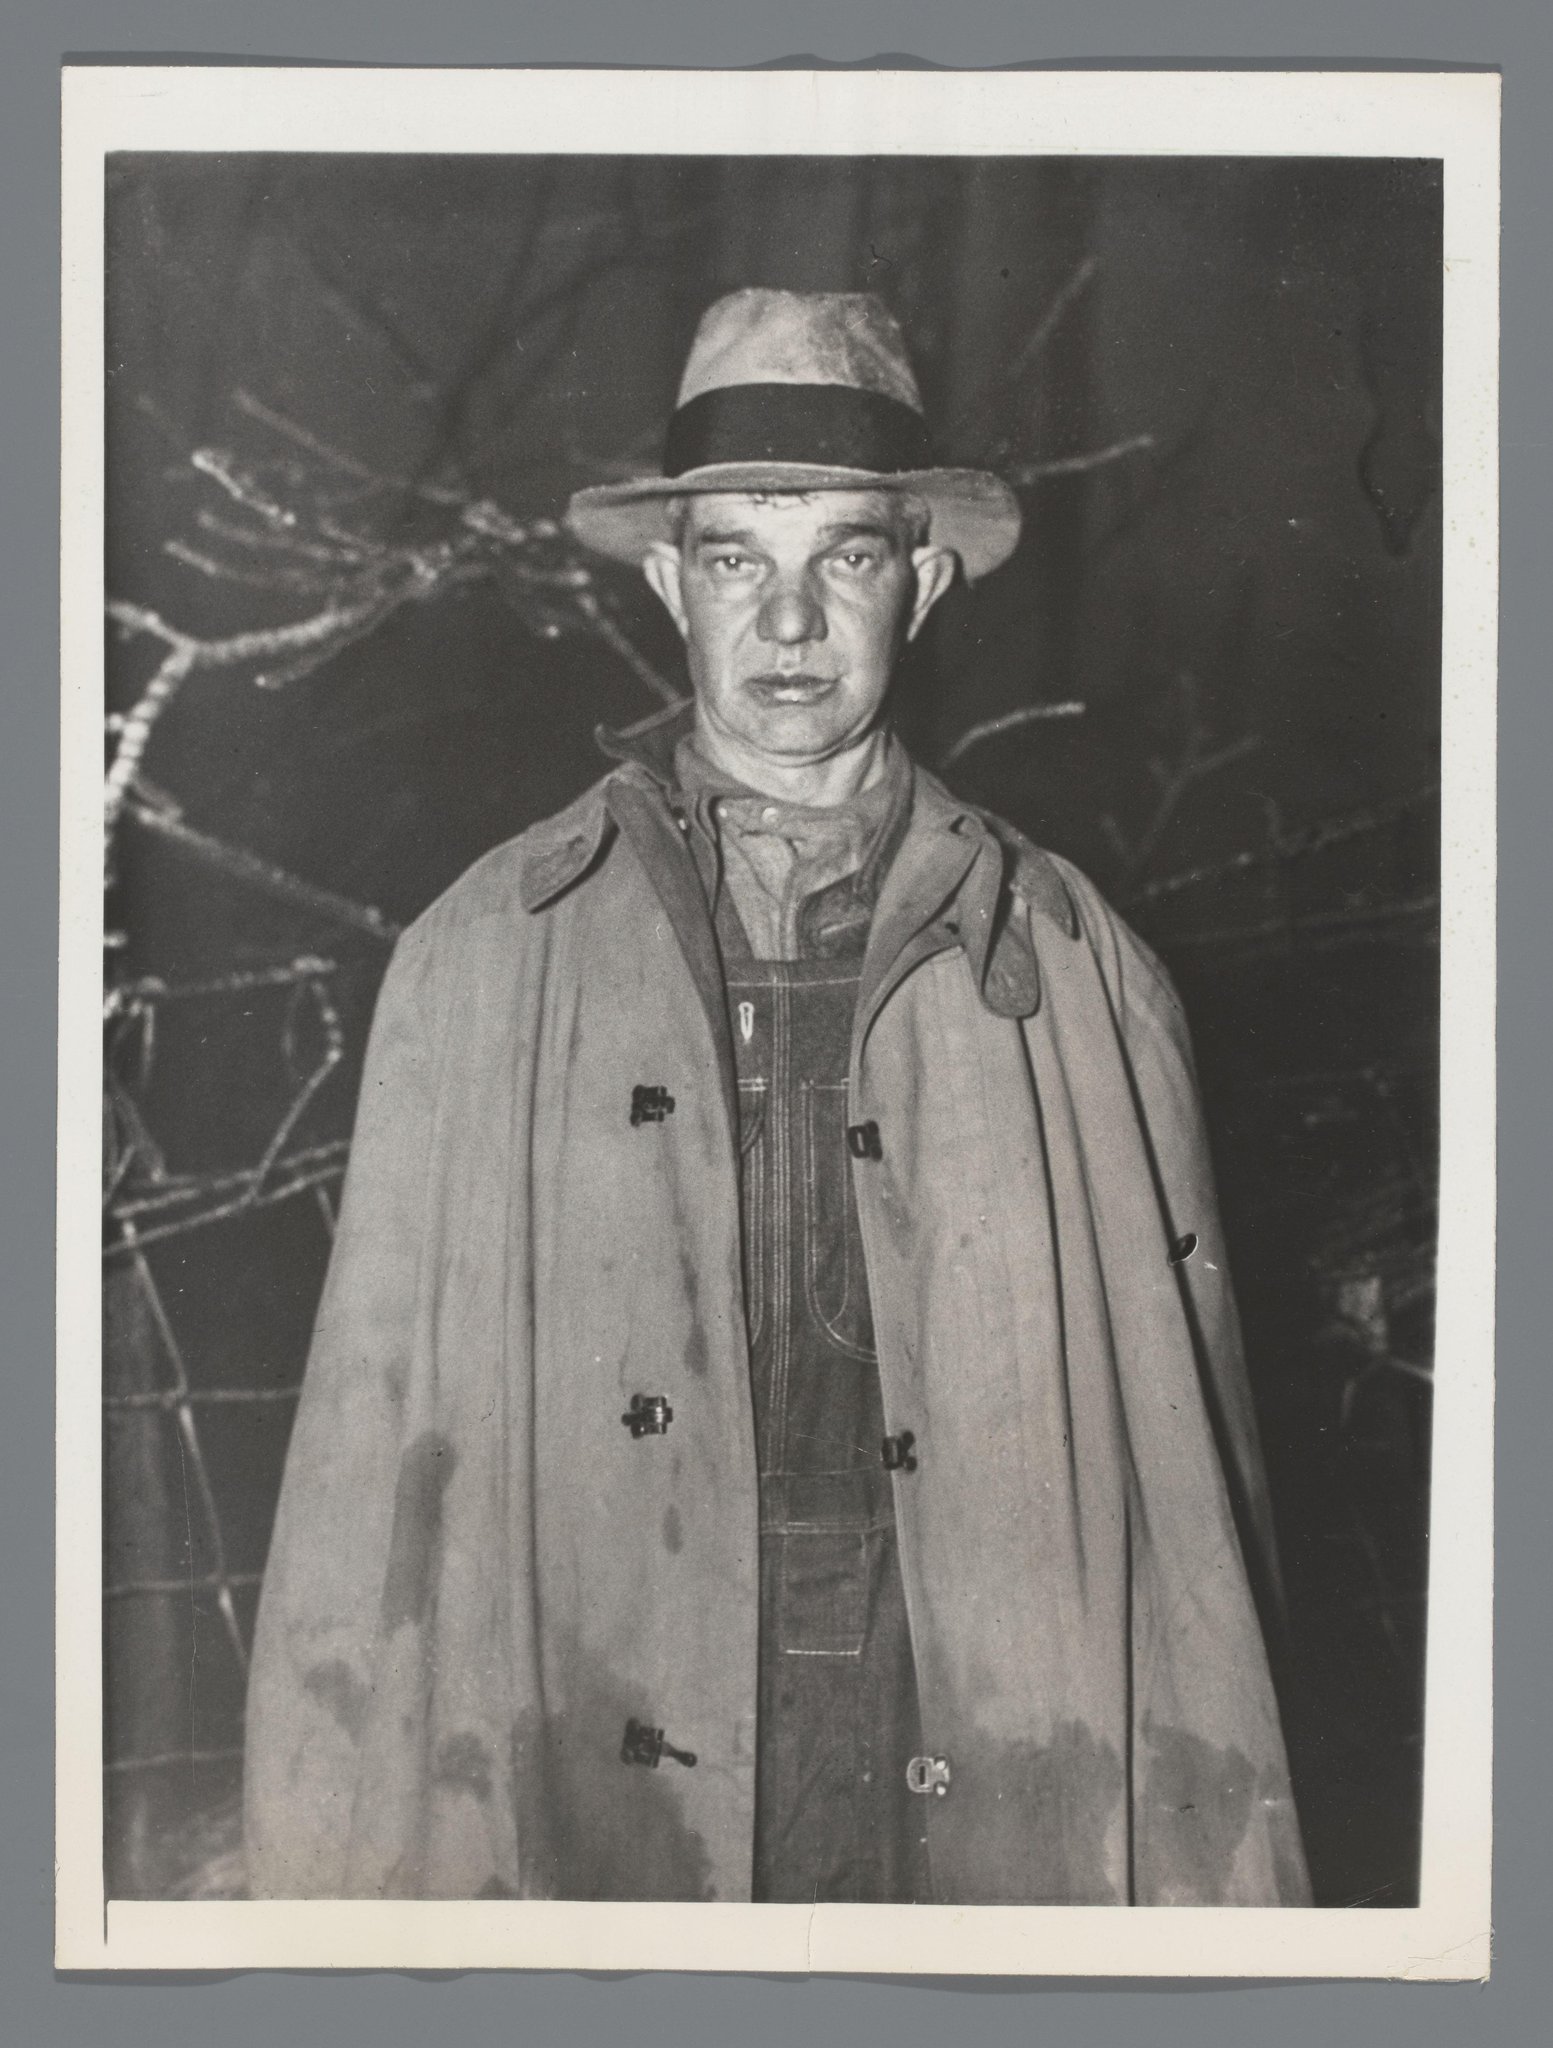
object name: photograph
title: Portret van Ernest Williams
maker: Anonymous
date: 1937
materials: paper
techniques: gelatin silver print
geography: united states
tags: adult man, historical persons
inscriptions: inscription: ‘REF. DEPT./ 2-5 37/ N.E.A.’, number: ‘1740612’, inscription: ‘W379376 SOUGHT AID FOR WRECKED BOMBER Ernest Williams, of Front Royal, Va., is the man who ran three miles to the army remount depot, near Front Royal, to obtain aid for the men in the army bomber which crashed there, JAN 28th, in a fog so dense that visibility was restricted to a 20 foot radius. Two men, including the pilot, were killed, and three others were burned in varying degrees. CREDIT LINE (ACME) 1/29/37 BU’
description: Ernest Williams rende drie mijl om hulp te halen voor de bemanning van een neergestort militair vliegtuig.